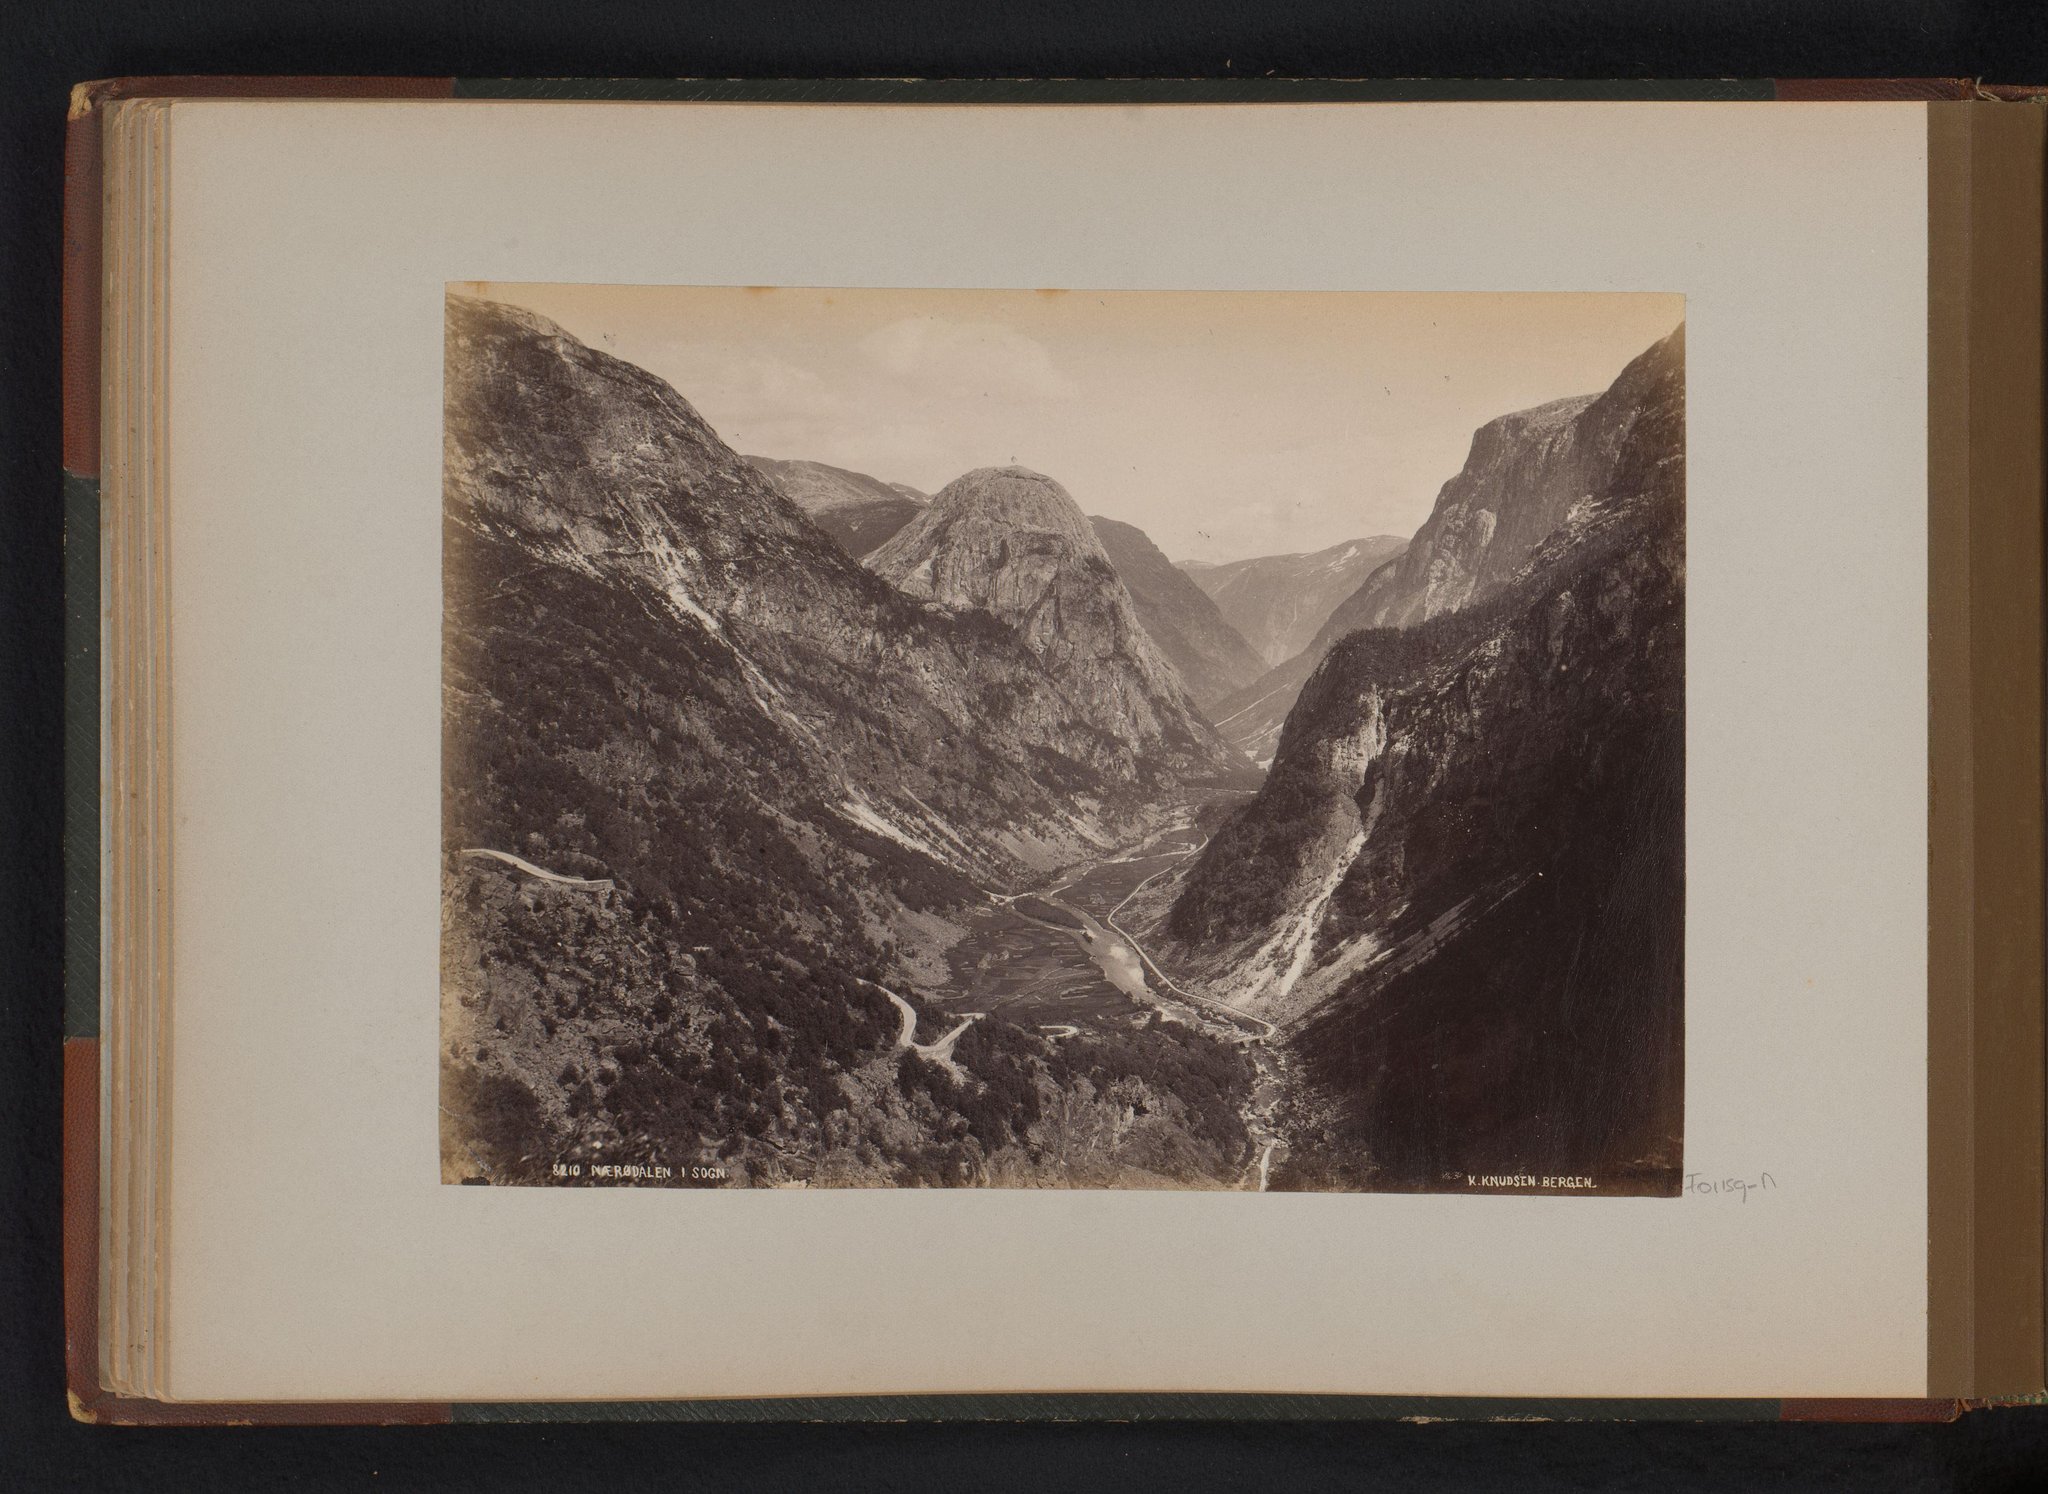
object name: photograph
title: Gezicht op het Nærødalen in Noorwegen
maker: knud knudsen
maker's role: fotograaf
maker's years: 1832-1915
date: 1880-1898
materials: photographic support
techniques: albumen print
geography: norway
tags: dale, valley, norway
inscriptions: number: ‘8210’, name: ‘K. Knudsen. Bergen.’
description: Onderdeel van Reisalbum met opnames van bezienswaardigheden in Zweden, Noorwegen, Denemarken, Beieren, Milaan en Parijs.